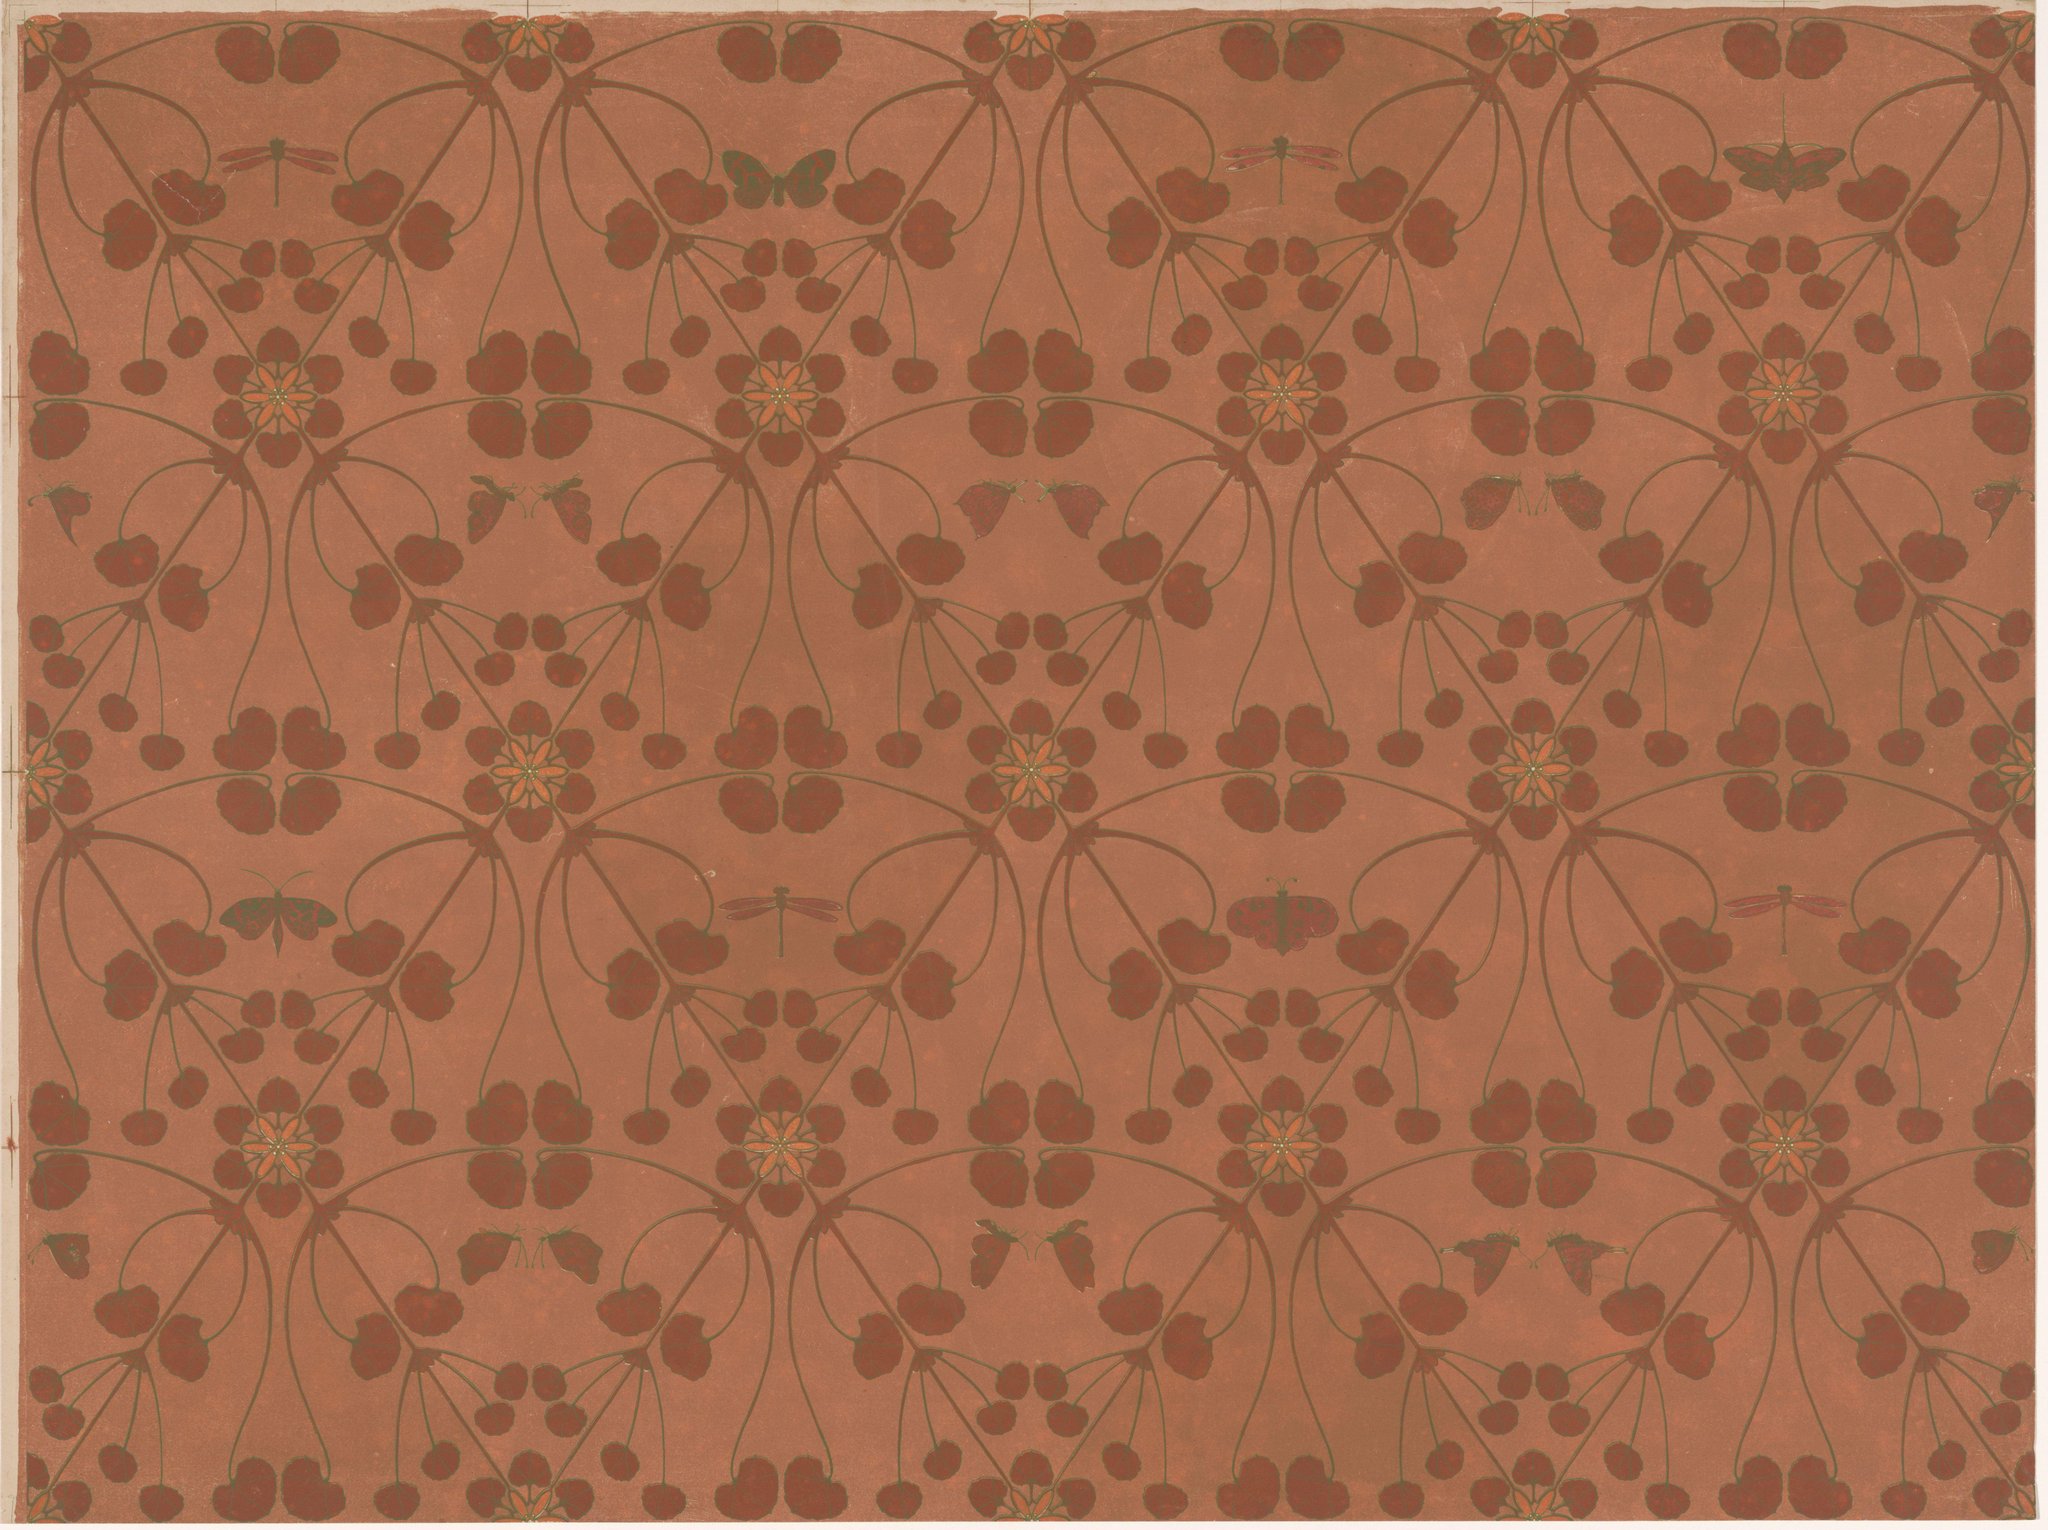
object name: print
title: Behangpapier met kleine bladeren, vlinders en libellen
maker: theo nieuwenhuis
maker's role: designer, draughtsman, print maker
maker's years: 1866-1951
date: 1876-1951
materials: paper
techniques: lithograph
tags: flowers, insects: dragon-fly, insects: butterfly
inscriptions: collector's mark: Lugt 2760, collector's mark: Lugt 2228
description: Ontwerp voor behangpapier met schermbloemen, vlinders en libellen.